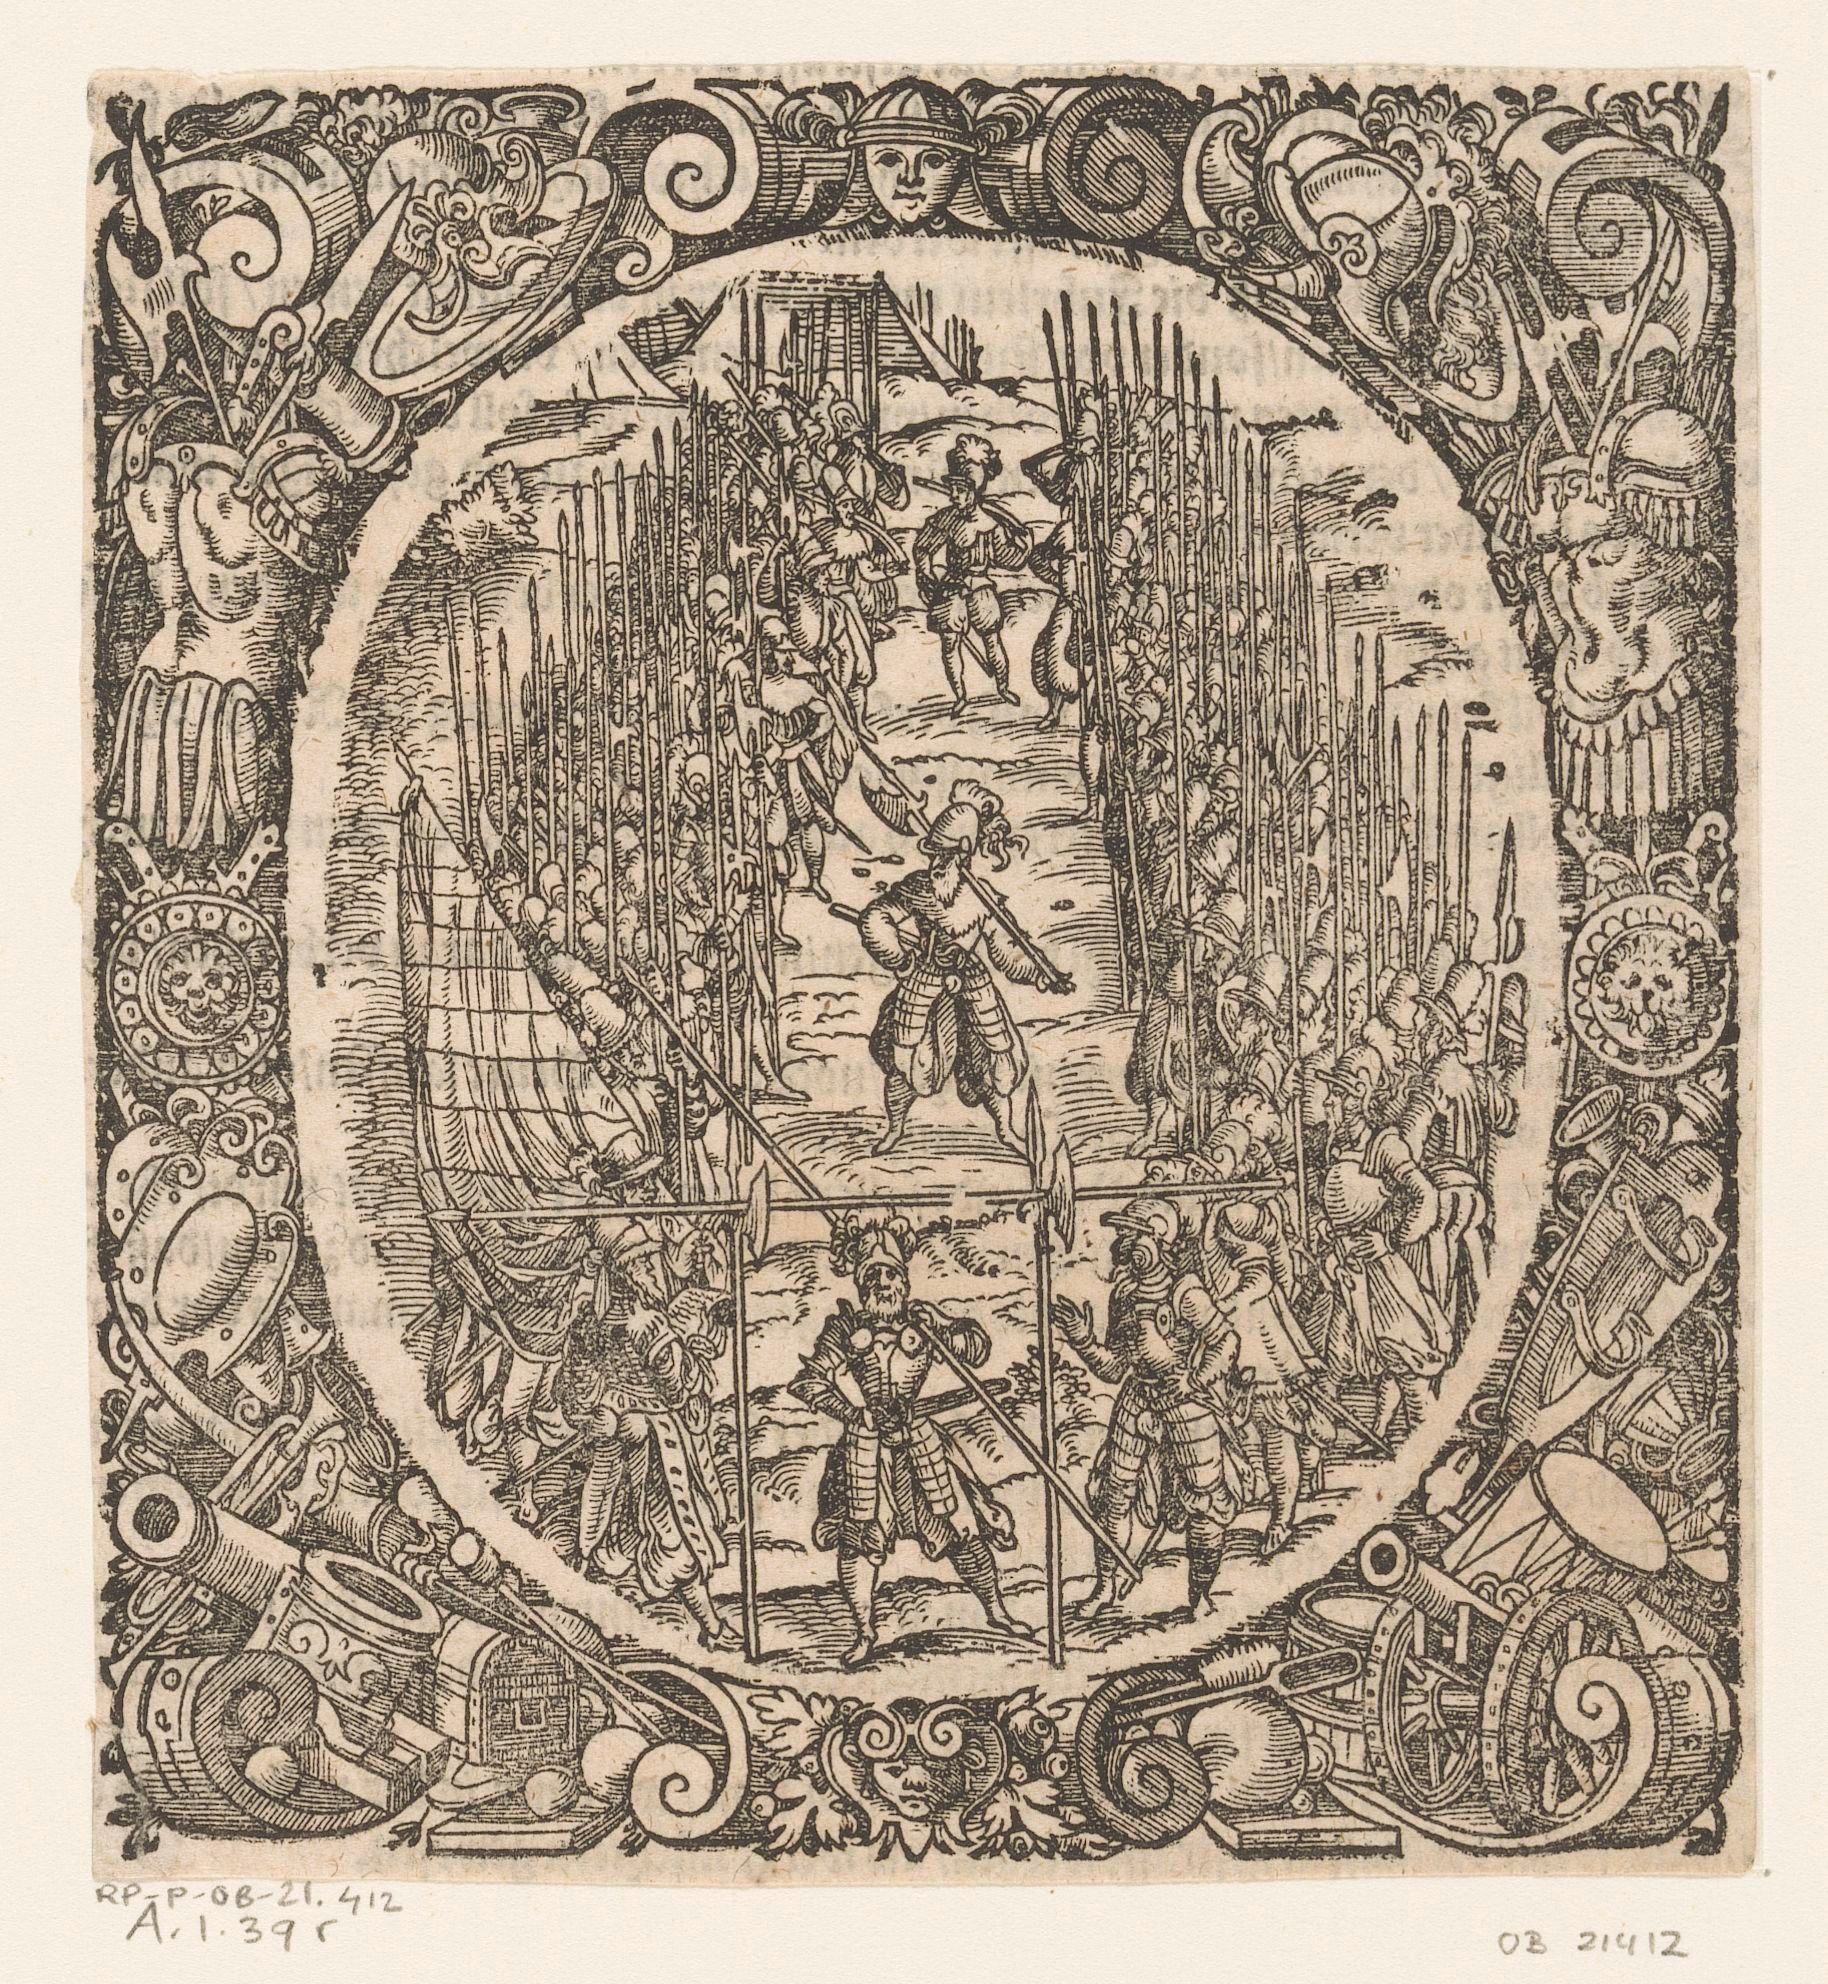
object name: book illustration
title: Keuring van landsknechten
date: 1573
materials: paper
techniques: woodcut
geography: nuremberg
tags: warfare; military affairs, the soldier; the soldier's life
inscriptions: collector's mark: Lugt 240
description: Zowel de voorstelling als de ornamentrand werd gebruikt voor verschillende edities van Leonhardt Fronspergers Kriegsbuch.